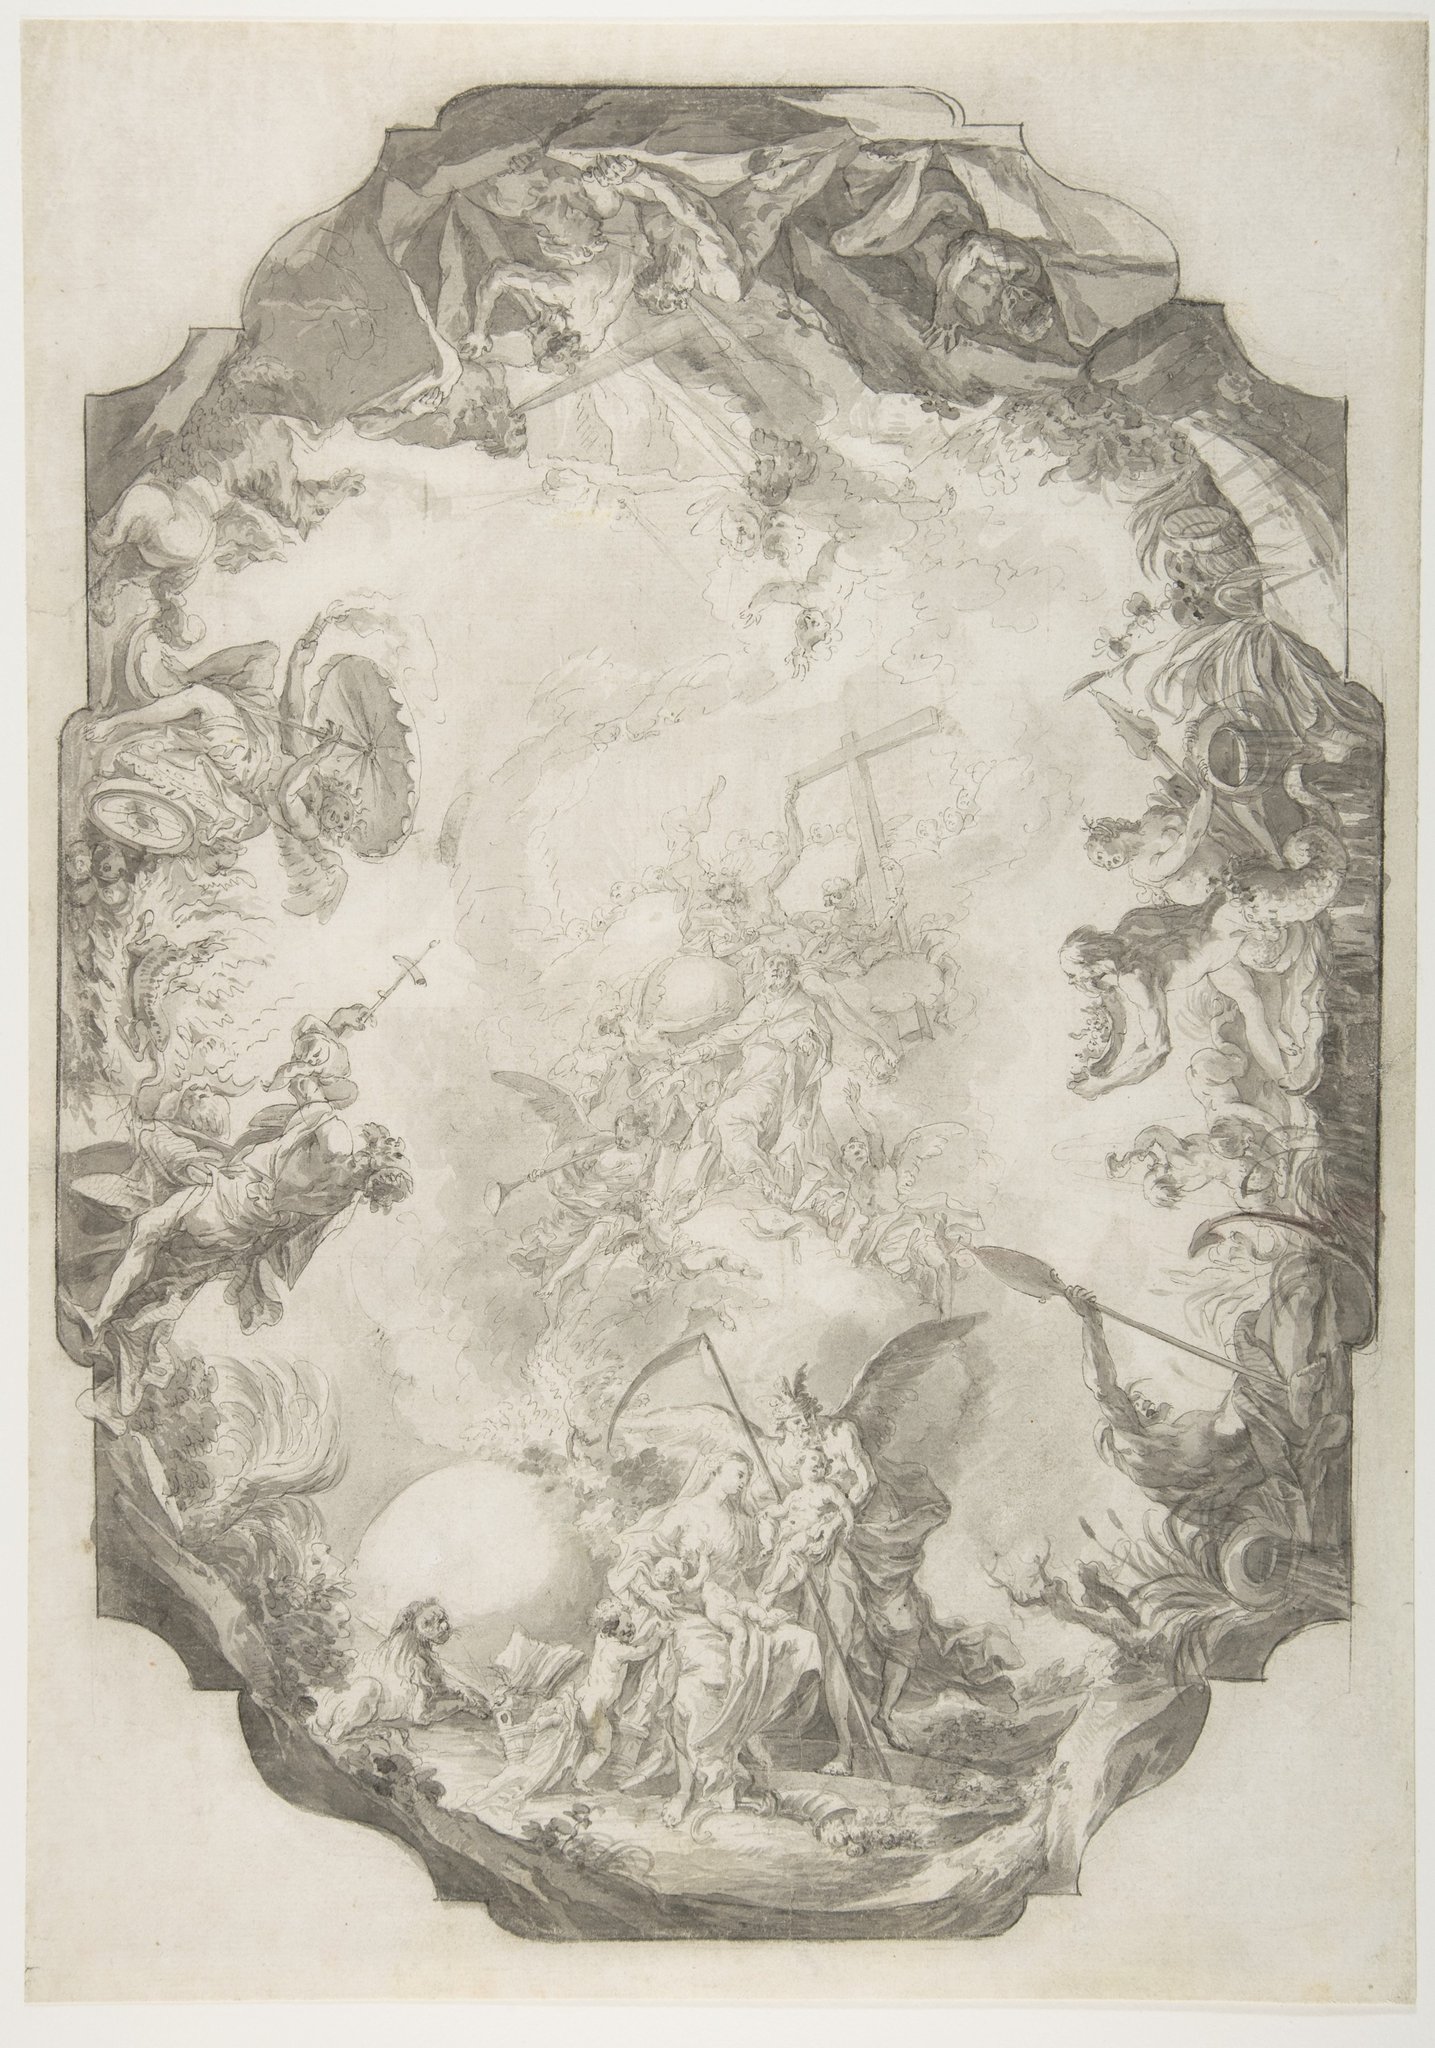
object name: drawing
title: The Apotheosis of a Saint, Project for a Ceiling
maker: johann anwander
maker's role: artist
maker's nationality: german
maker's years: 1715-1770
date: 1701-1800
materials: chalk, ink, paper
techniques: brush, pen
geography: germany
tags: saints